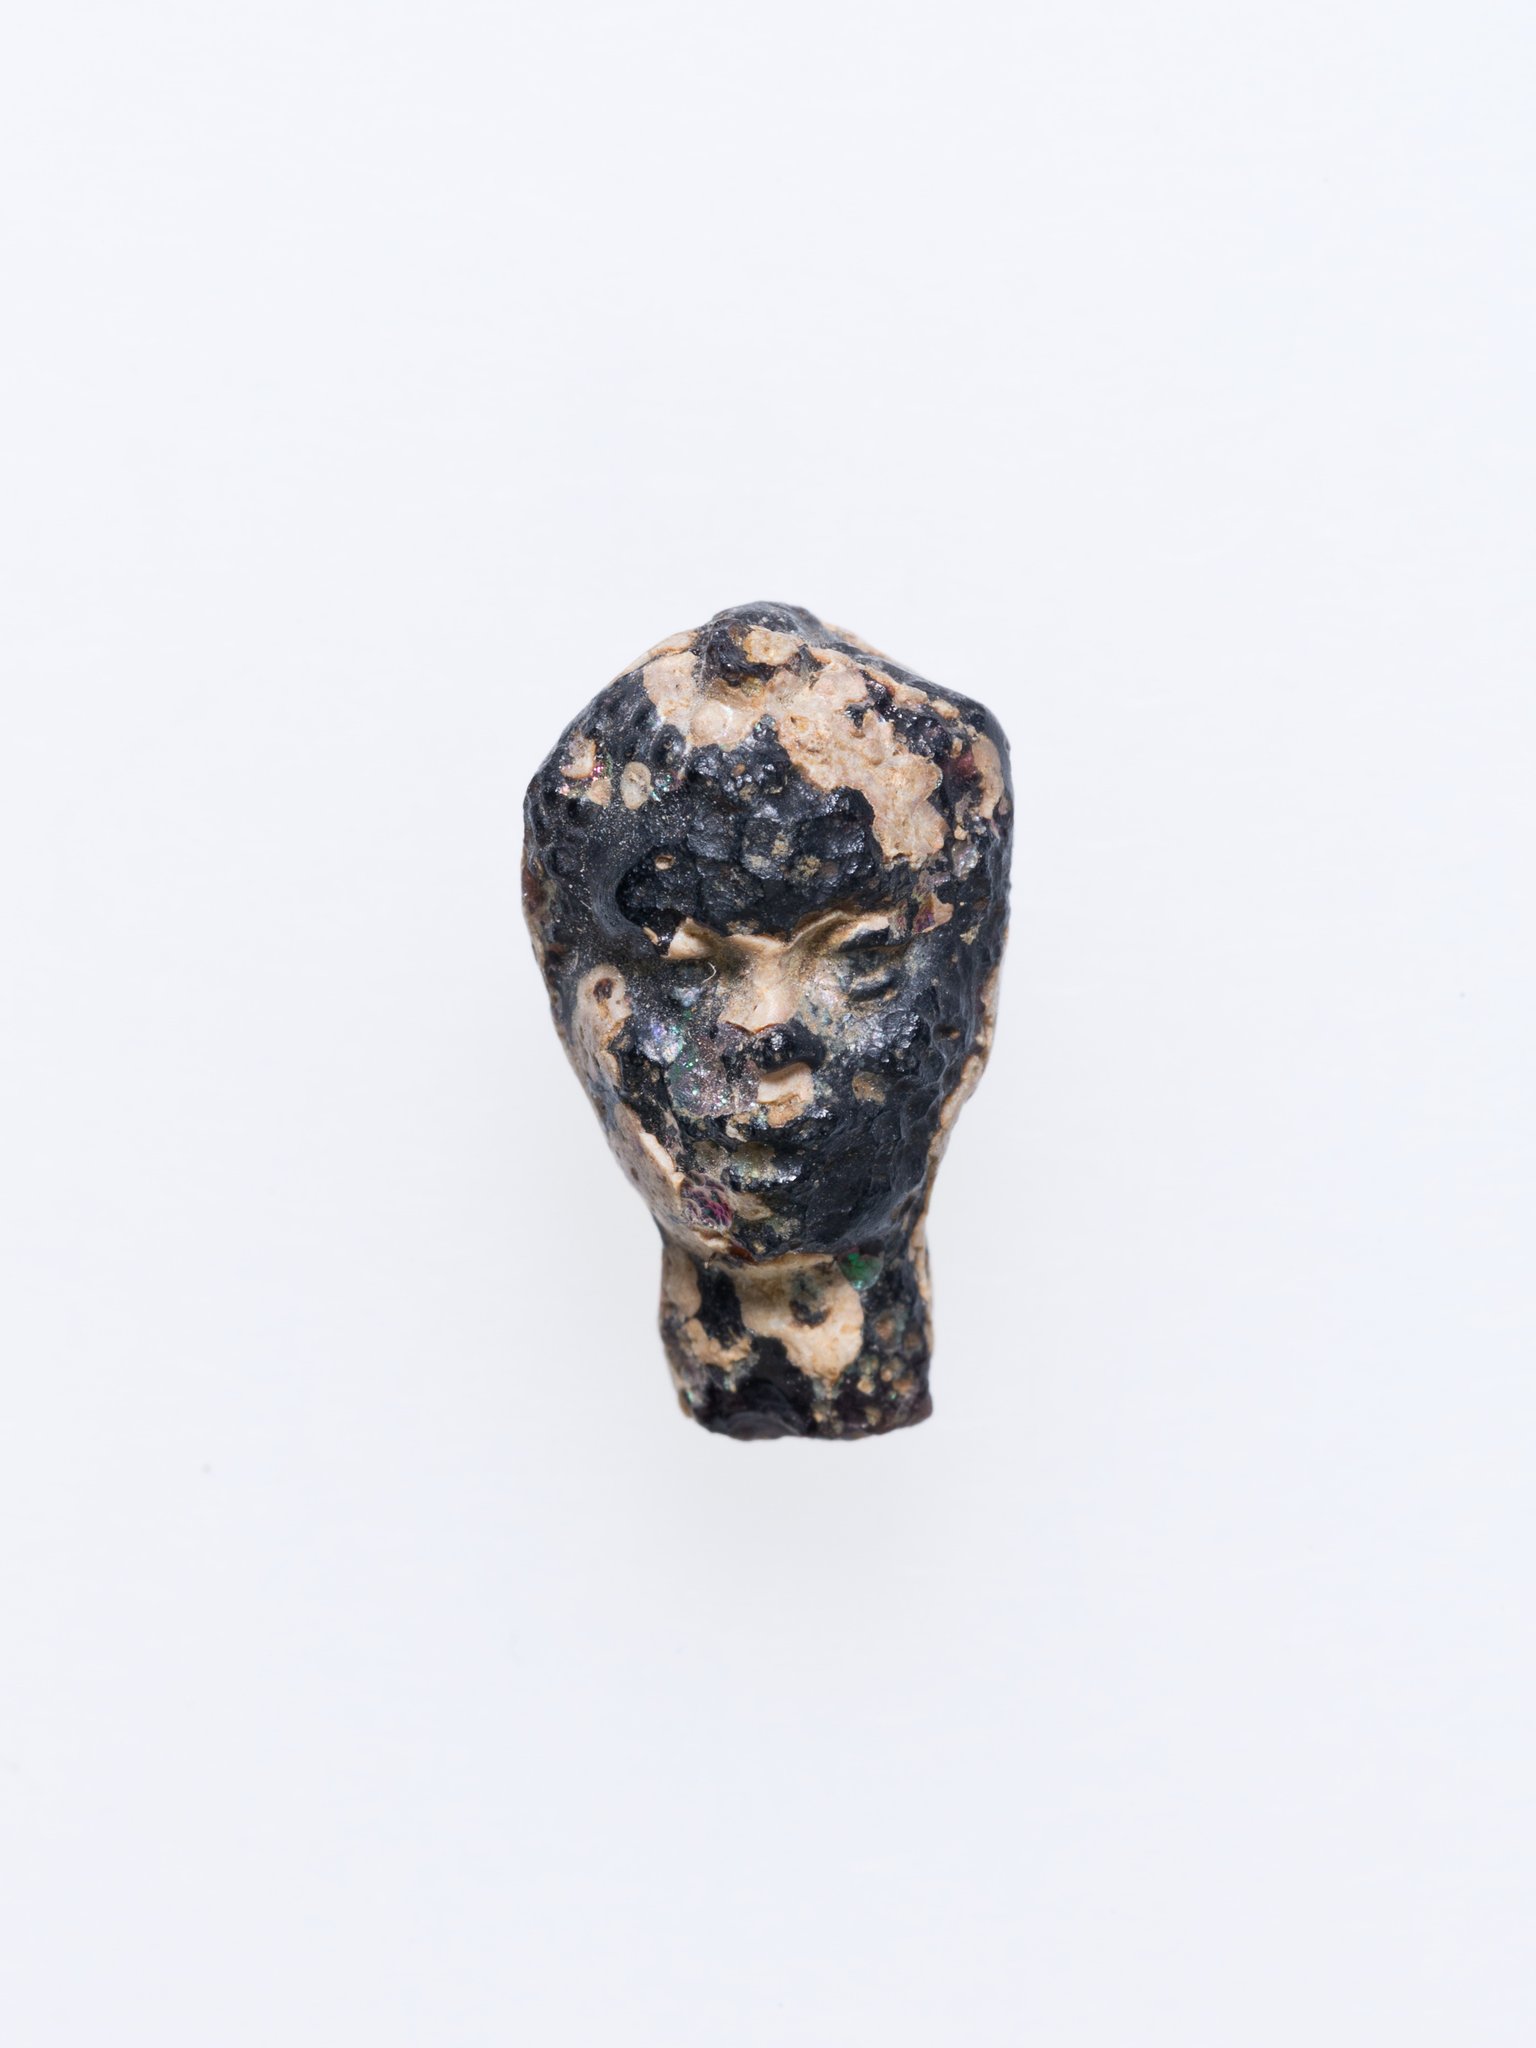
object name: amulet, head, boy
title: Hellenistic-style head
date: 200 BCE-100 CE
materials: glass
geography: egypt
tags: heads